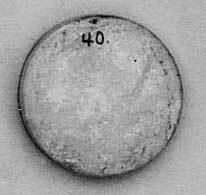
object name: fragment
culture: burmese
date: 1902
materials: jade